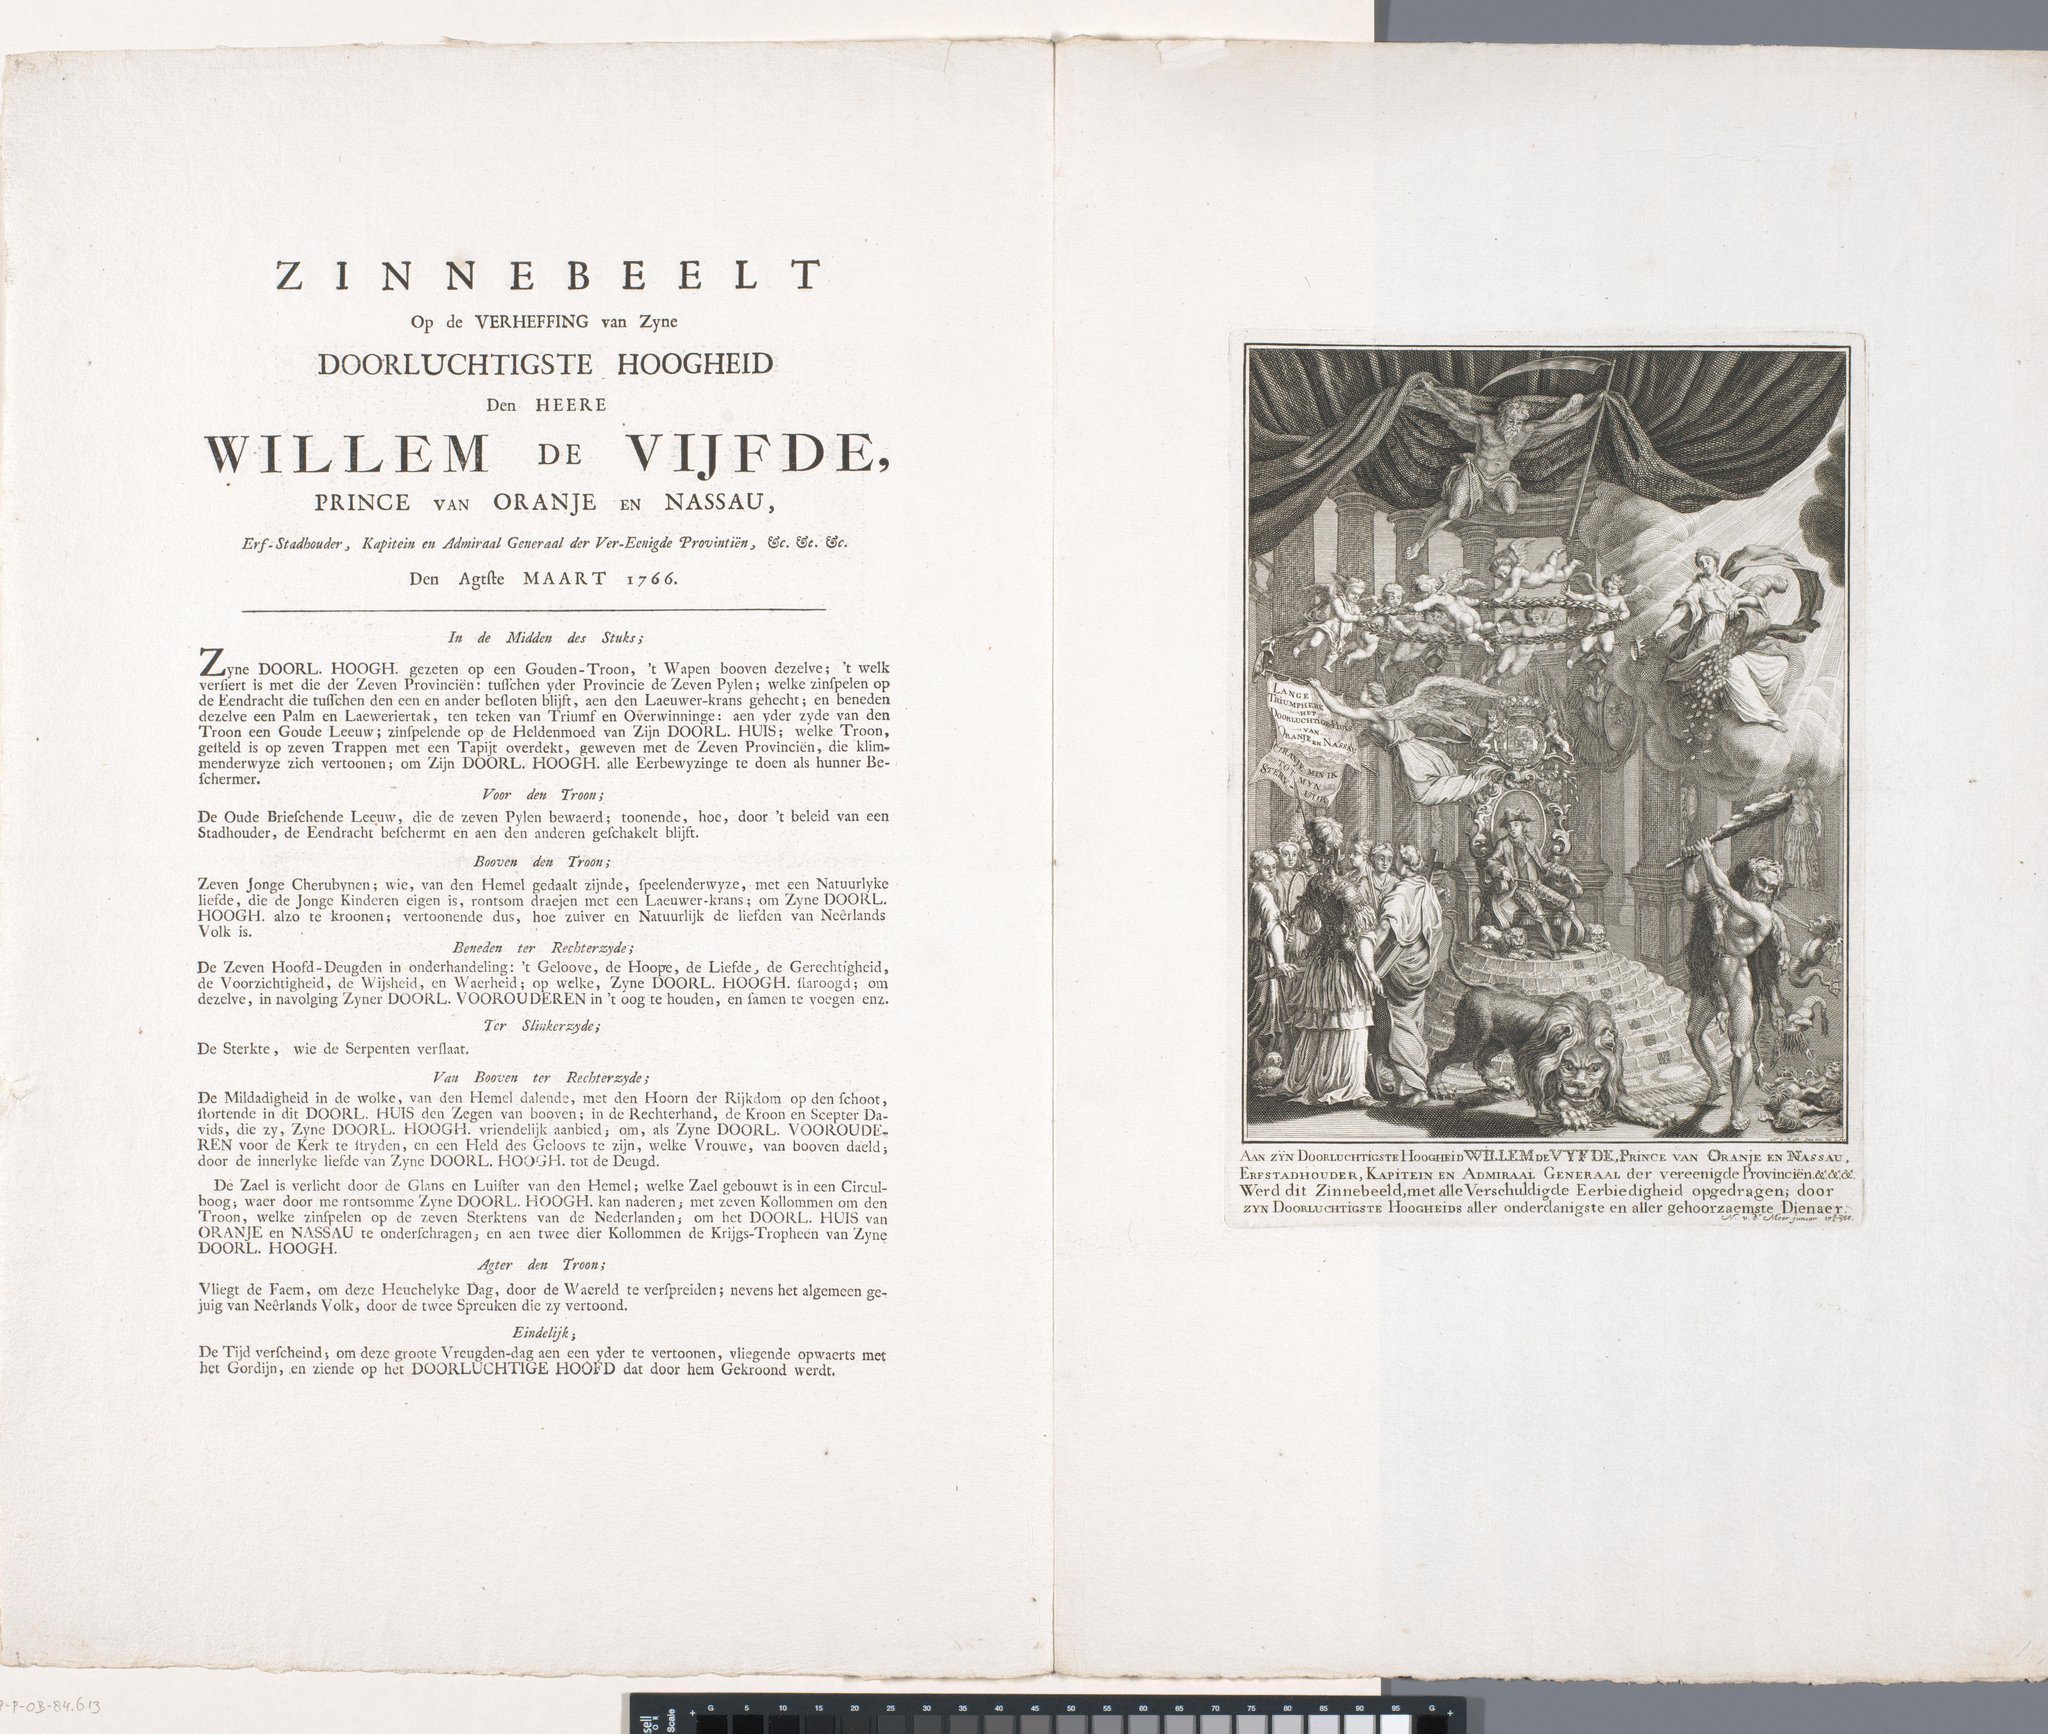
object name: text sheet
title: Zinnebeelt Op de Verheffing van Zyne Doorluchtigste Hoogheid Den Heere Willem de Vijfde, Prince van Oranje en Nassau, Erf-Stadhouder, Kapitein en Admiraal Generaal der Ver-Eenigde Provintiën (...) Den Agste Maart 1766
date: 1766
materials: paper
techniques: engraving, etching, letterpress printing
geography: northern netherlands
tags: william v (prince of orange), the seven virtues (symbolized), fame; 'fama', 'fama buona', 'fama chiara' (ripa), generosity, liberality; 'generosità', 'liberalità' (ripa), father time, man with wings and scythe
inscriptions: collector's mark: Lugt 2228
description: Dubbelgevouwen blad met rechts een allegorische voorstelling en links de gedukte uitleg van de plaat. Allegorie op de installatie van prins Willem V als erfstadhouder op achttienjarige leeftijd op 8 maart 1766. Centraal de prins zittend op zijn troon, rechts verslaat Hercules de serpenten, links de verzamelde zeven deugden. Boven de troon vliegt de Faam en openbaart de Tijd zeven cherubijnen met een grote lauwerkrans, rechts schenkt de Mildadigheid rijkdommen. Op de voorgrond de Nederlandse Leeuw. In het onderschrift in 4 regels de opdracht aan de stadhouder.